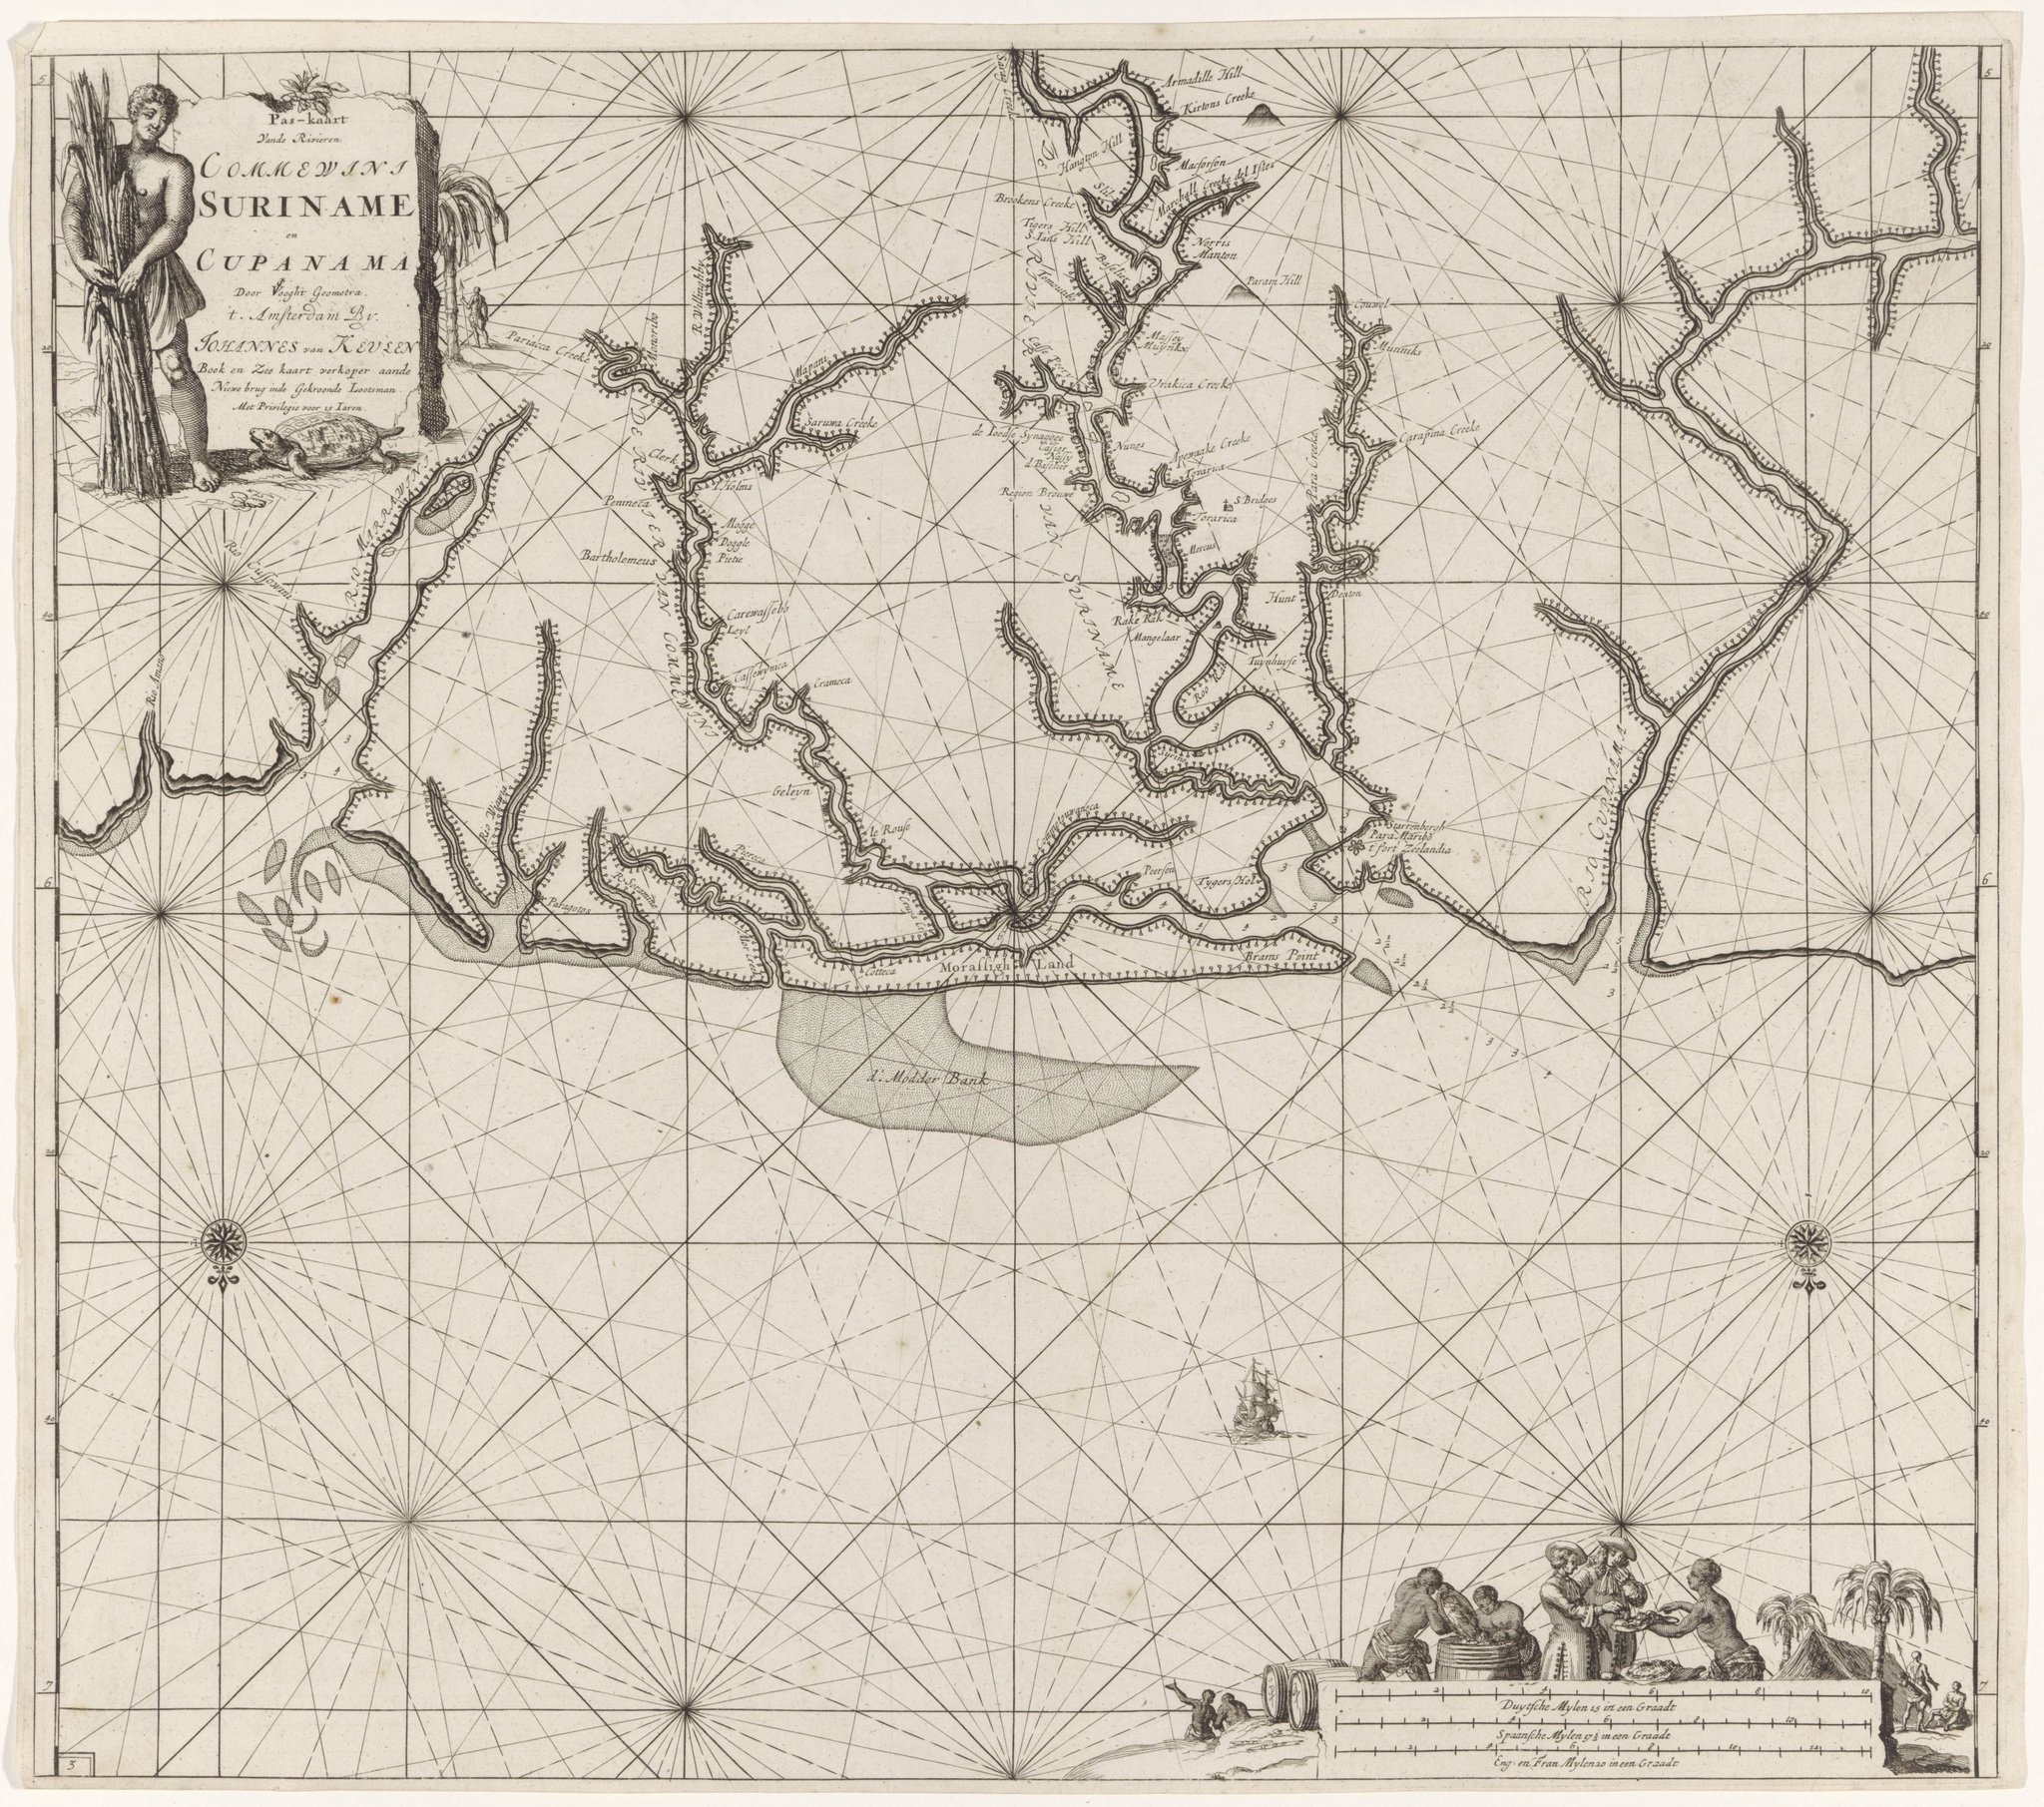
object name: print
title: Paskaart van verschillende Surinaamse rivieren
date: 1684-1799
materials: paper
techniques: engraving, etching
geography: amsterdam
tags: sailing-ship, sailing-boat, tortoises, turtles, test, trial (~ production), americans with african roots, african-americans, sugar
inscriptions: collector's mark: Lugt 2228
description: Paskaart van de uitmonding van verschillende Surinaamse rivieren in de Atlantische Oceaan, waaronder de Commewijne, de Coppename en de Surinamerivier, en haar uitmonding bij Paramaribo. Met twee kompasrozen, het Noorden ligt onder. Linksboven een dondere man met suikerriet en een schildpad bij de titel en het adres van de uitgever. Rechtsonder twee handelaren die handelswaar van een donkere man proeven, en enkele donkere mannen die werkzaamheden verrichten. Onder het tafereel de schaalverdeling, weergegeven in Duitse, Spaanse en Engelse of Franse mijlen (schaal: c. 1:450,000).